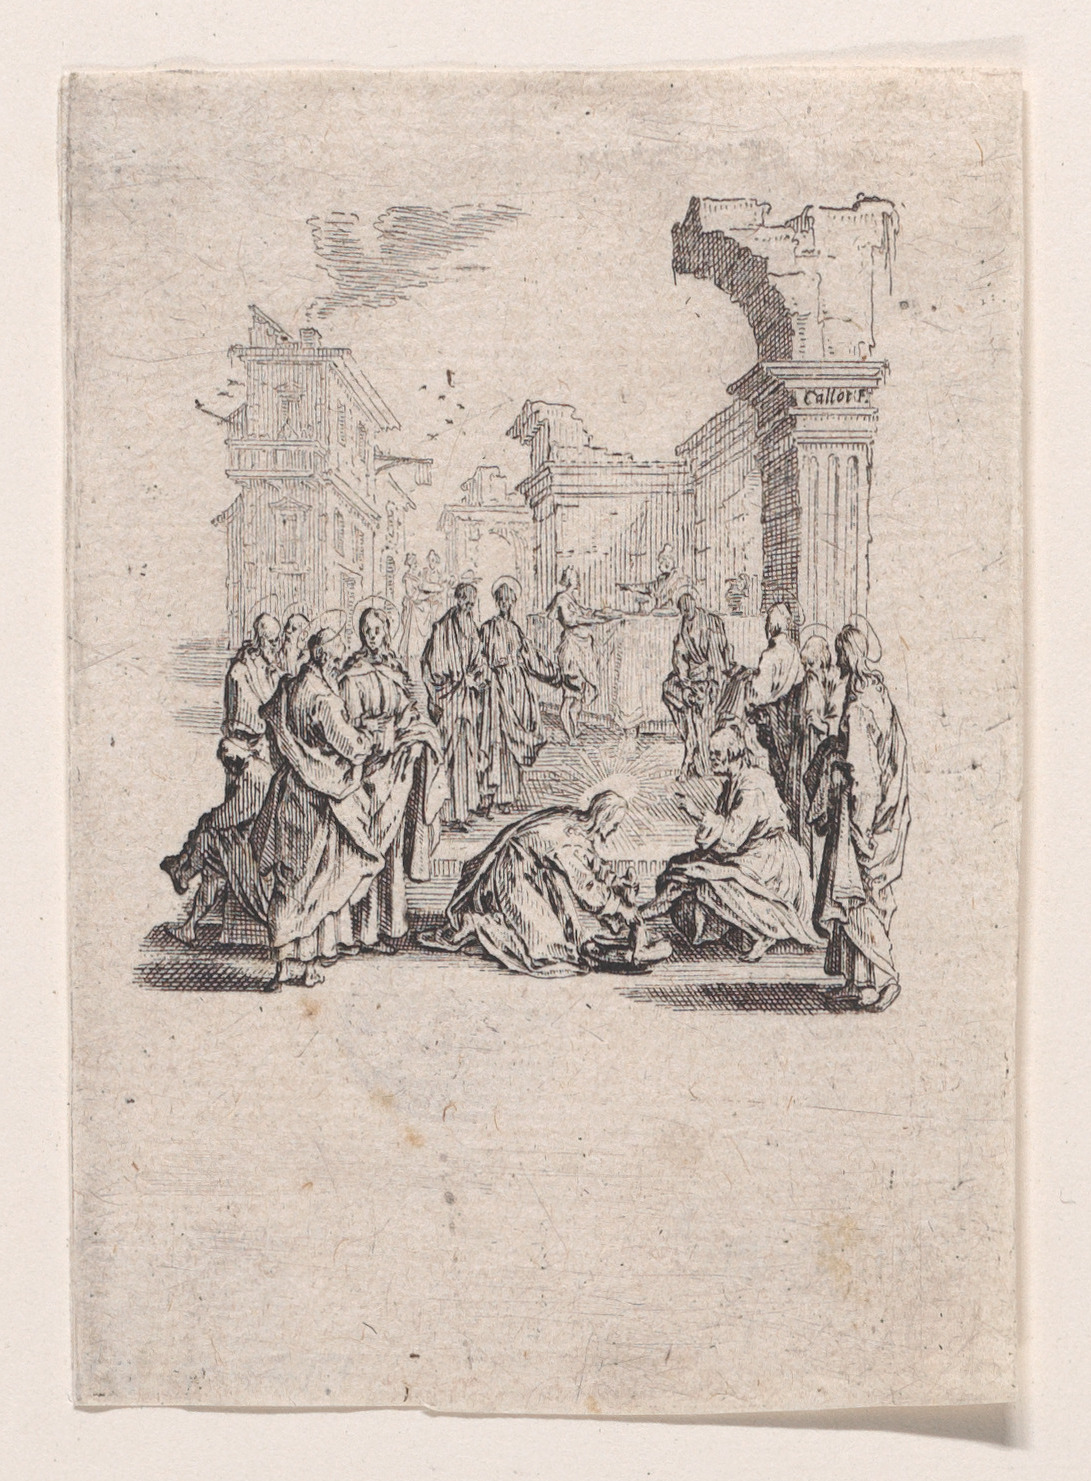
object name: print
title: Le Lavement des Pieds (The Washing of the Feet), from "La Petite Passion" (The Little Passion)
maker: jacques callot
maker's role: artist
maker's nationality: french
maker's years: 1592-1635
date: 1624-1625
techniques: etching